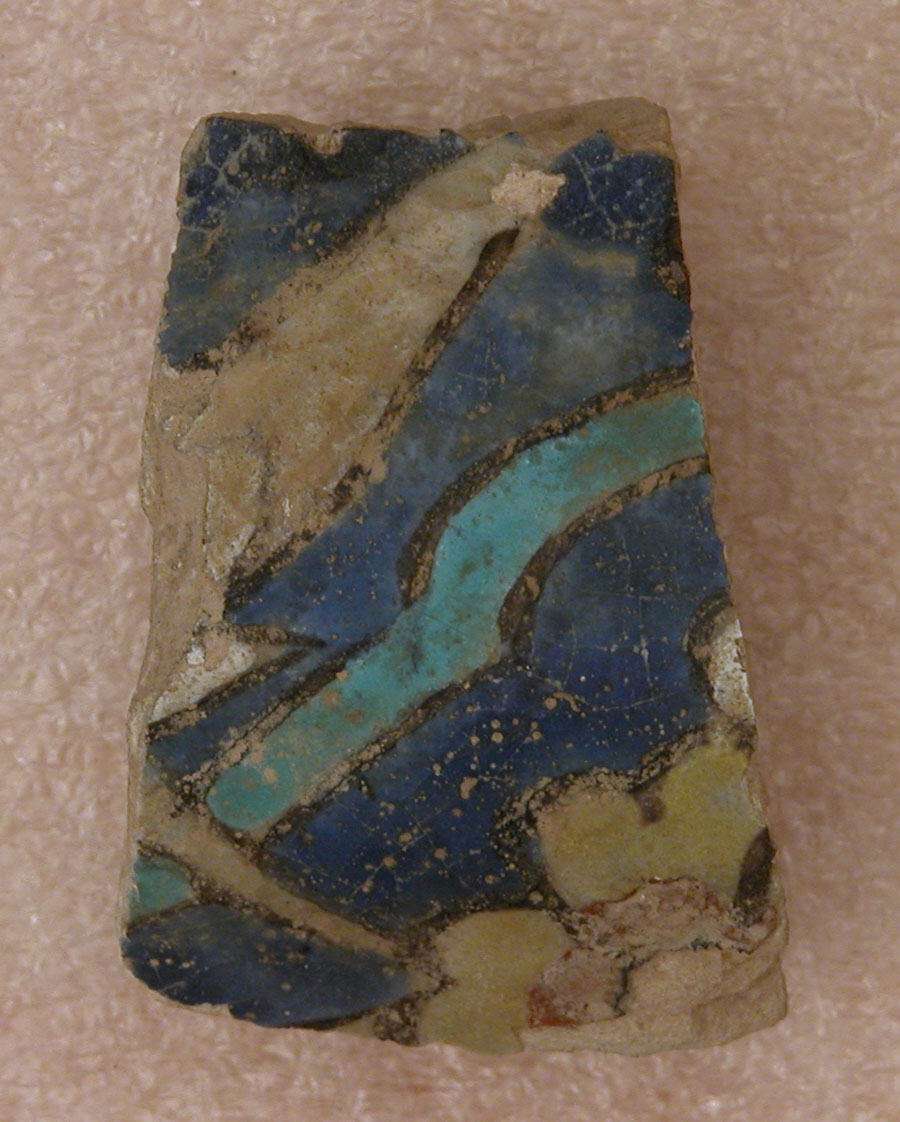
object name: tile fragment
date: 1334-1434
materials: glaze, stonepaste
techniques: painting, polychrome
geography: uzbekistan